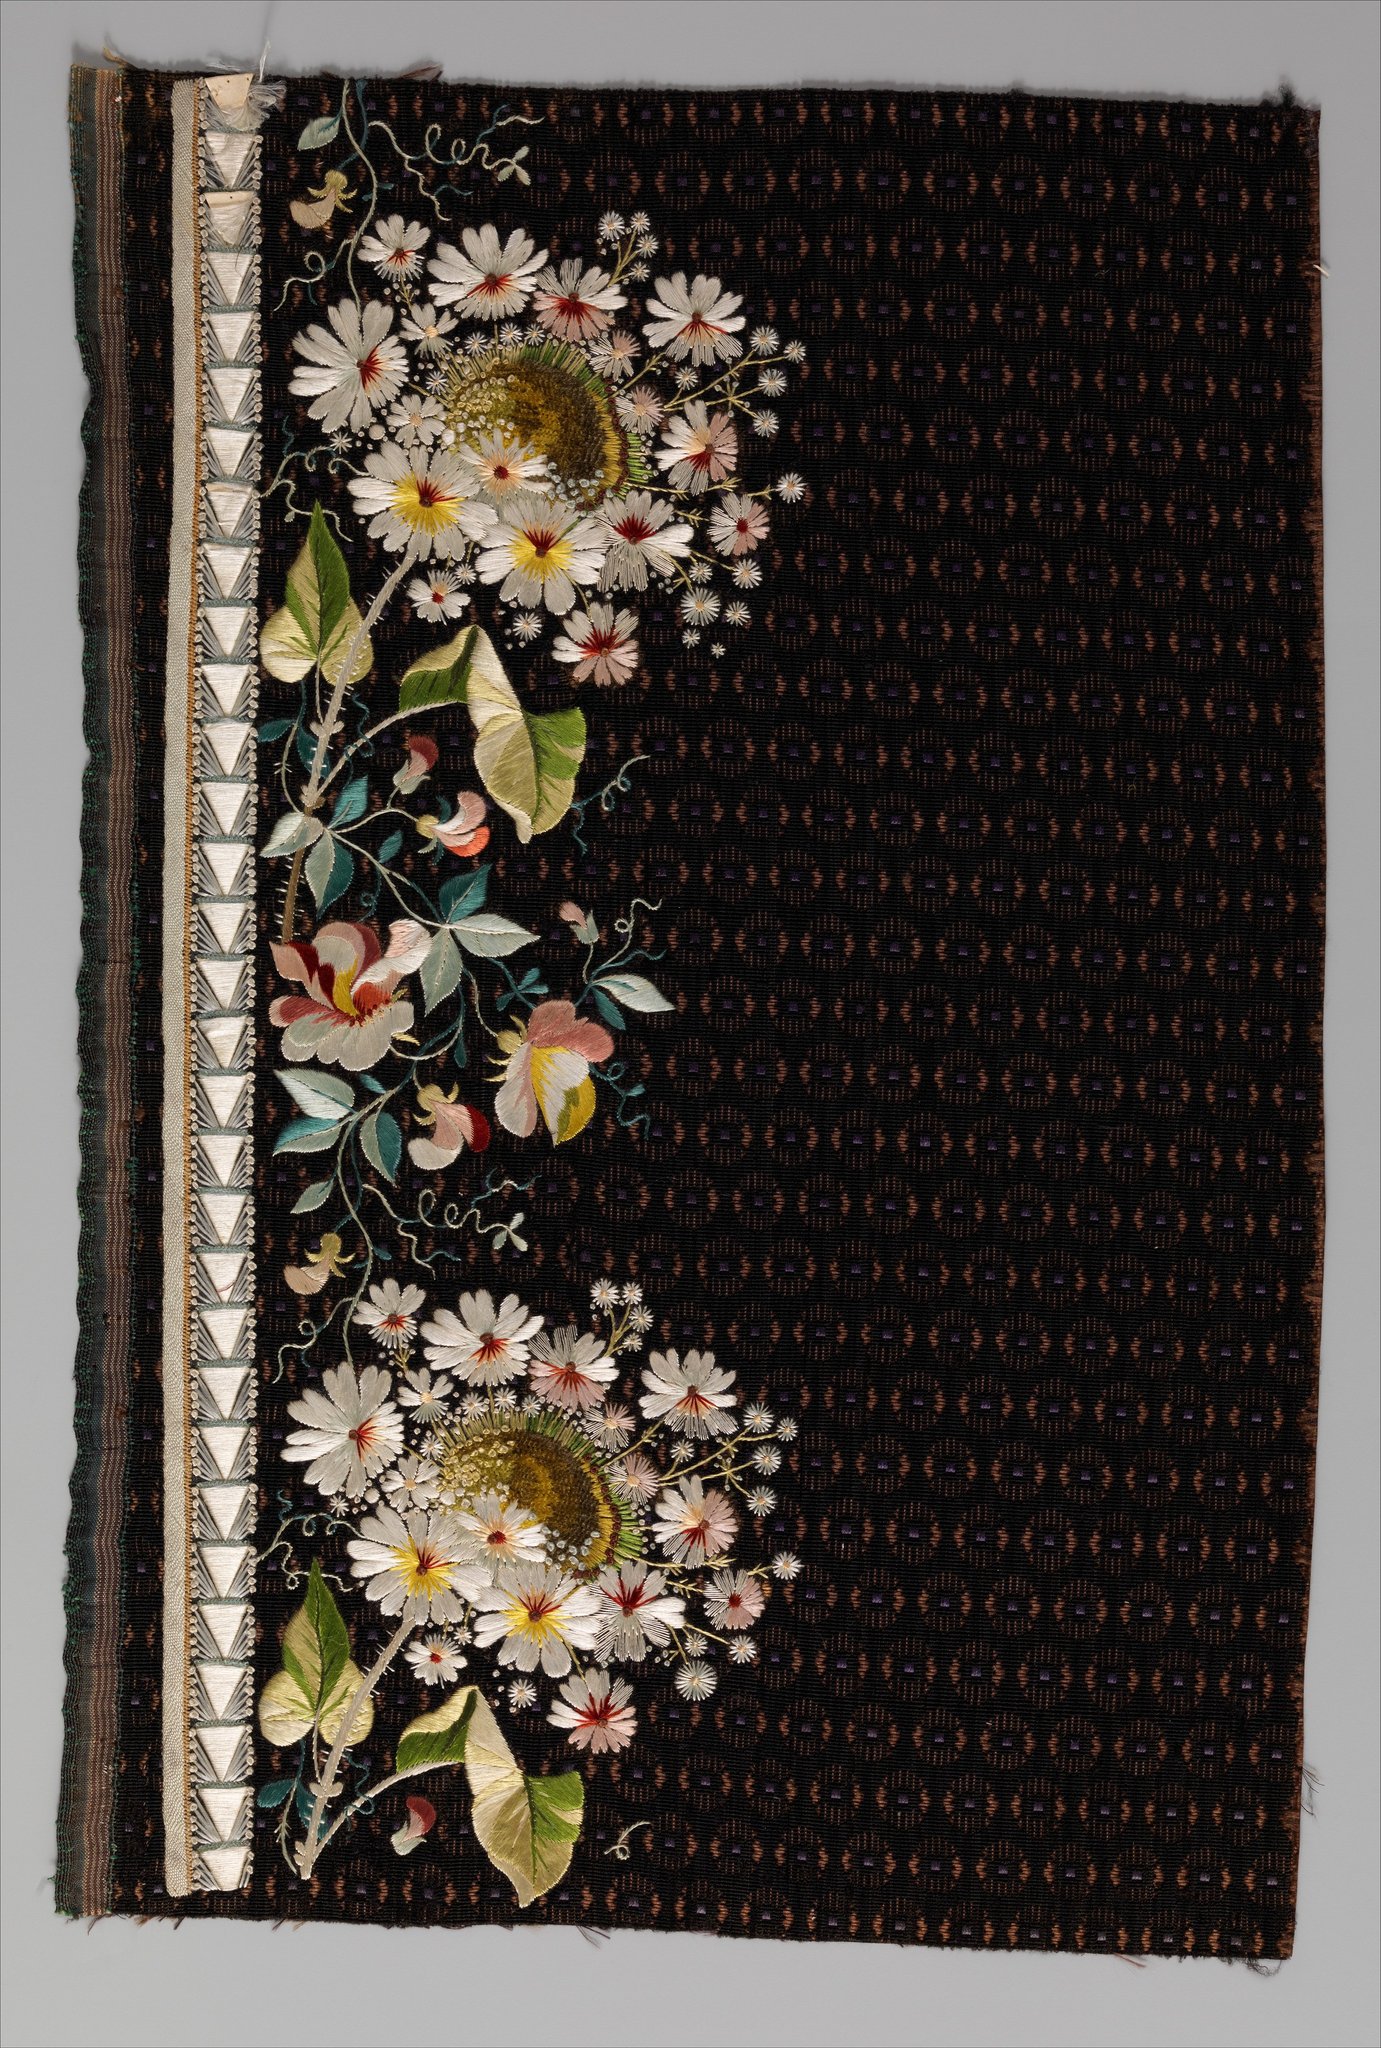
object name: sample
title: Embroidery sample for a man’s suit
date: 1800-1815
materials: silk, velvet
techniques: embroidery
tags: flowers